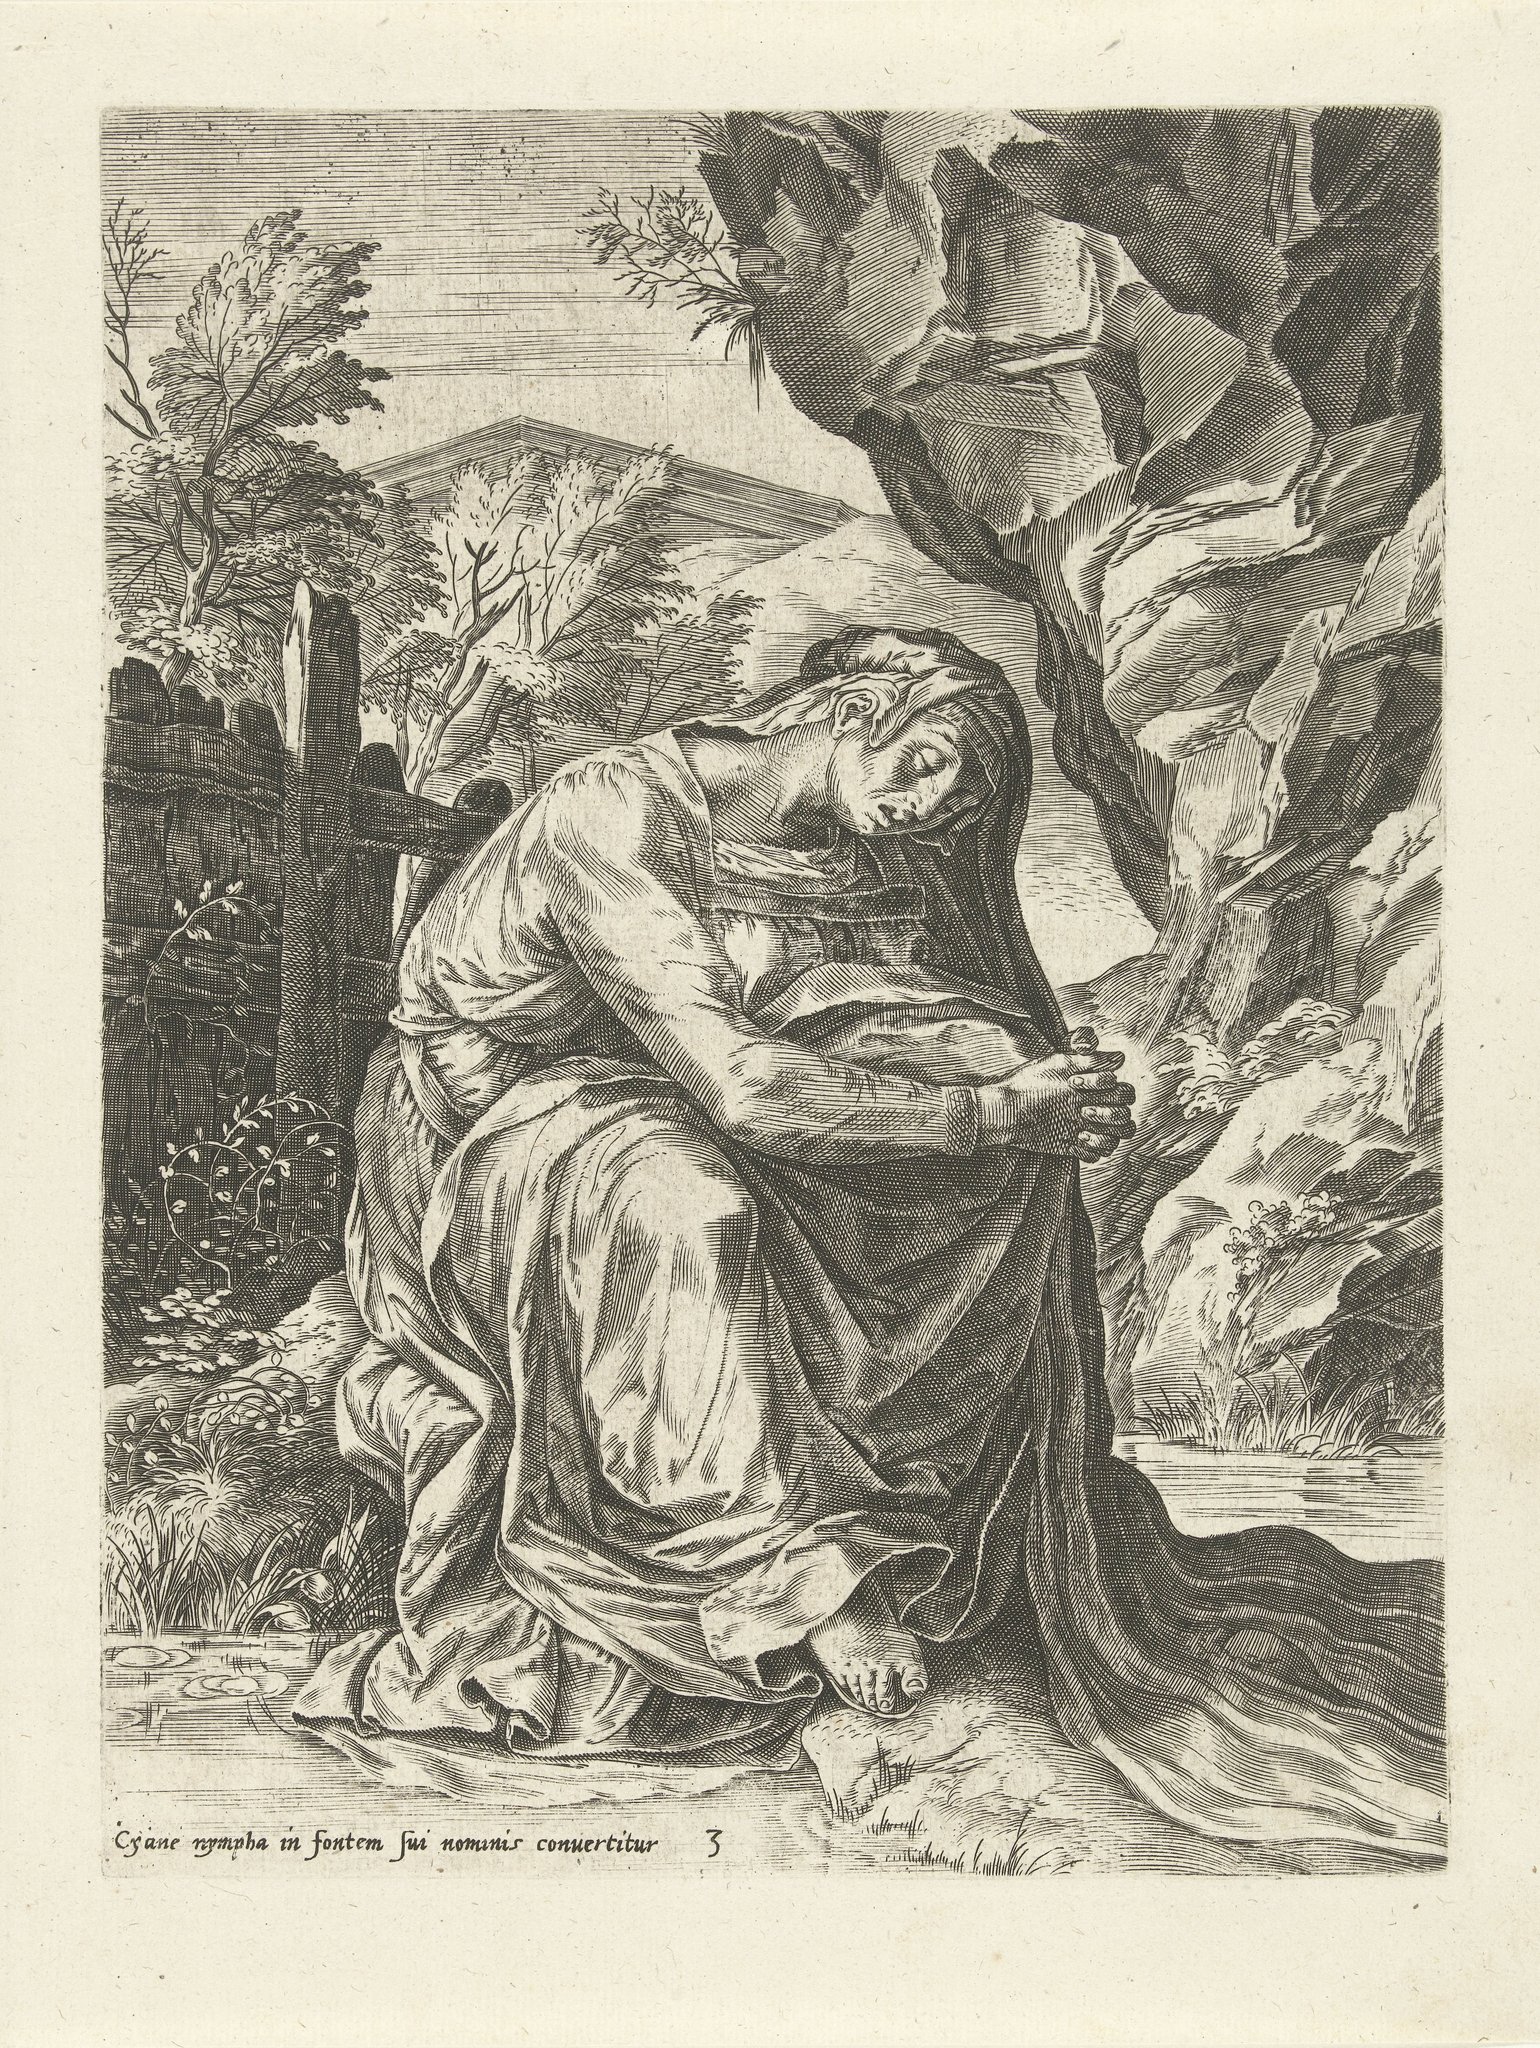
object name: print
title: Cyane verandert in een rivier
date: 1565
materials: paper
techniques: engraving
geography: antwerp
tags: cyane changed into a fountain: when trying to stop pluto from abducting proserpina, the nymph cyane is changed into a fountain (ovid, metamorphoses v 411)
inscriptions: collector's mark: Lugt 2228, collector's mark: Lugt 2760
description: De nimf Cyane , een vriendin van Proserpina, verandert uit droefheid over de roof van Proserpina in een bron van een rivier.